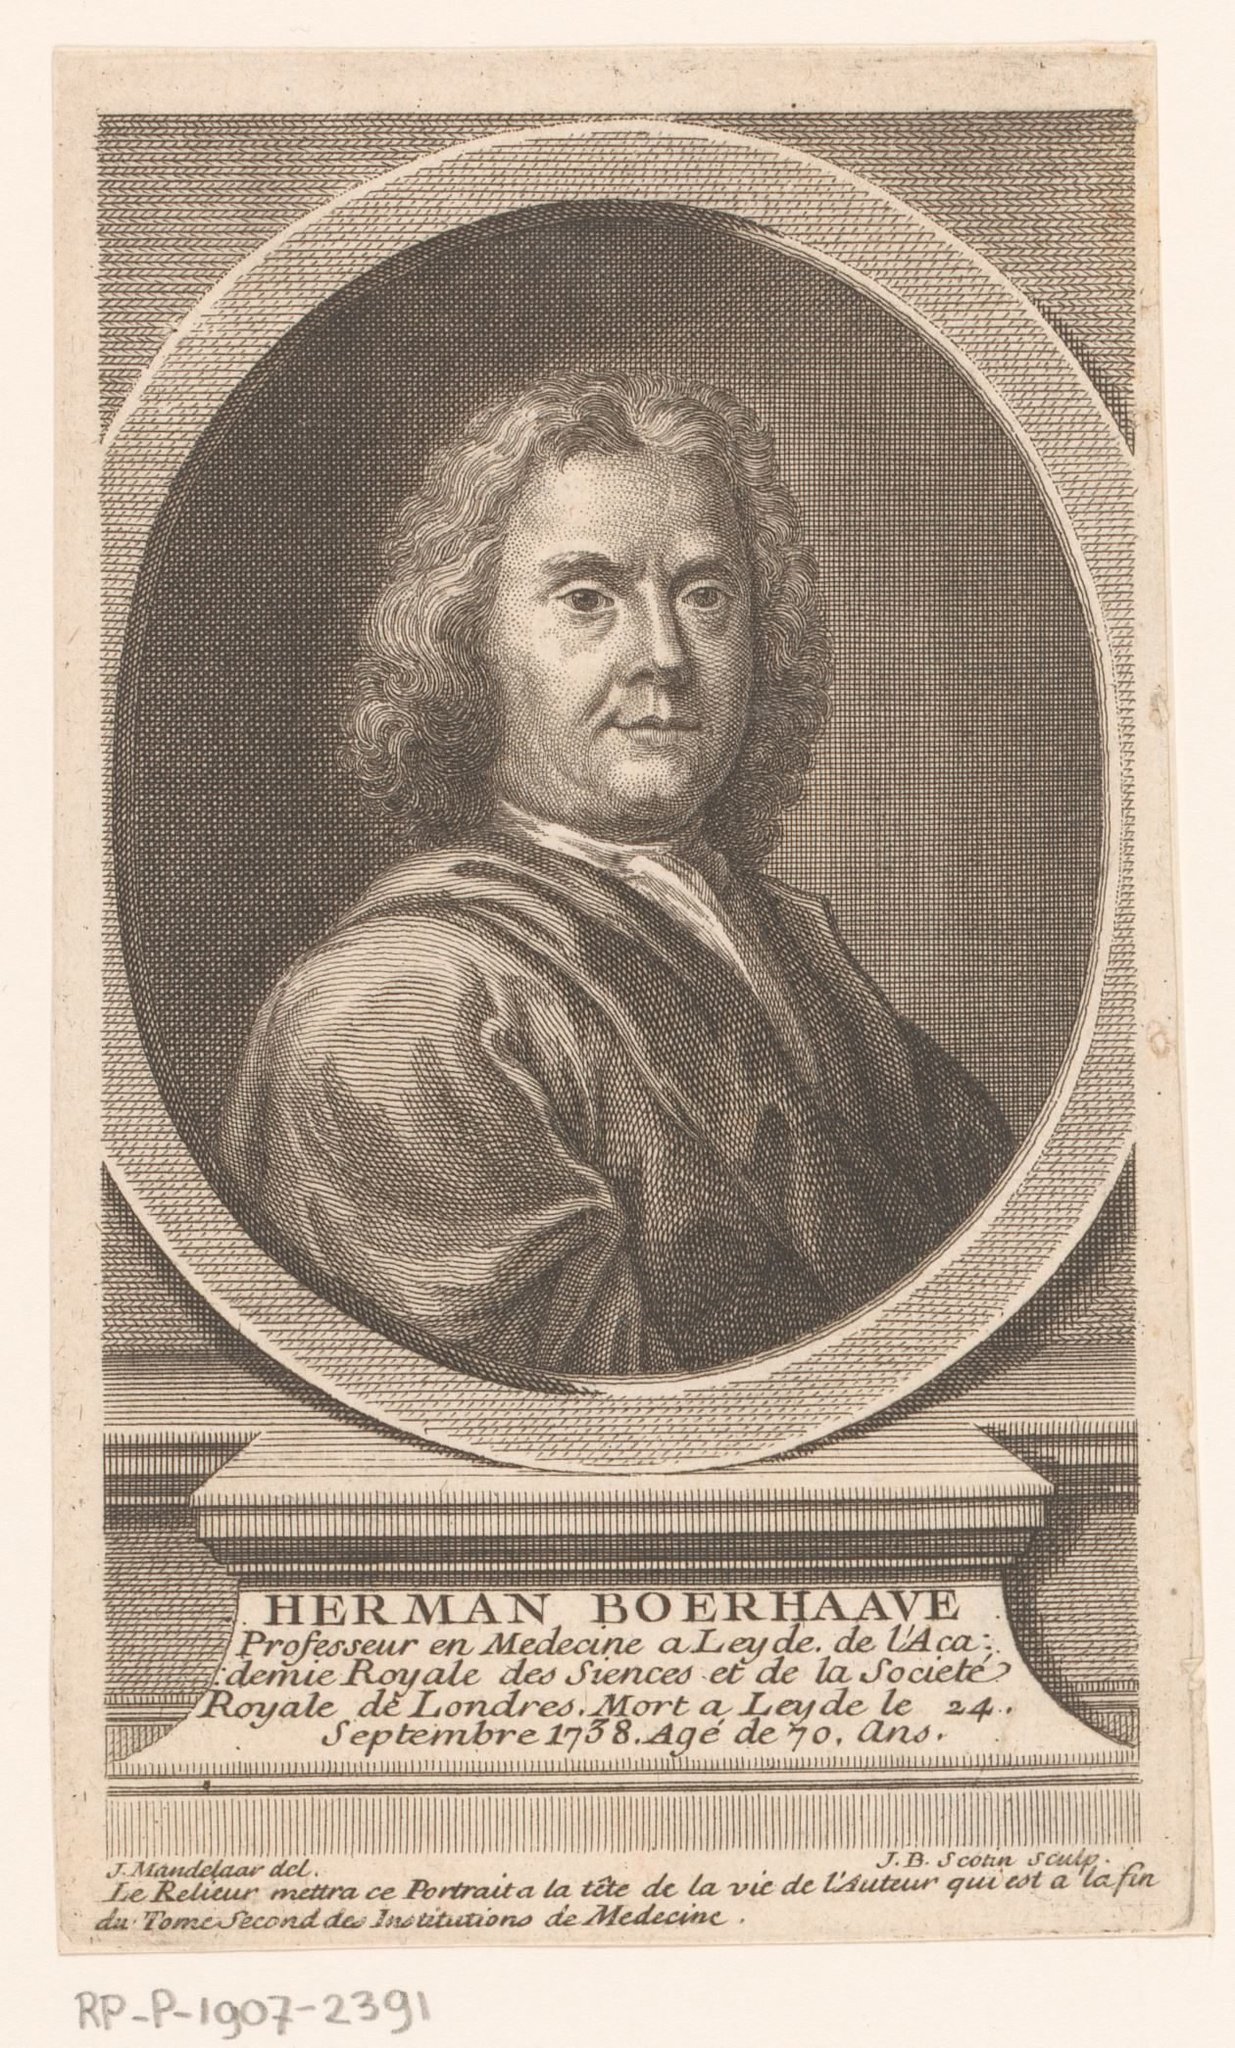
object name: print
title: Portret van Hermanus Boerhaave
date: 1738-1788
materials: paper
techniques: engraving, etching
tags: leiden, hermanus boerhaave, historical persons, professor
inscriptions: collector's mark: Lugt 2228